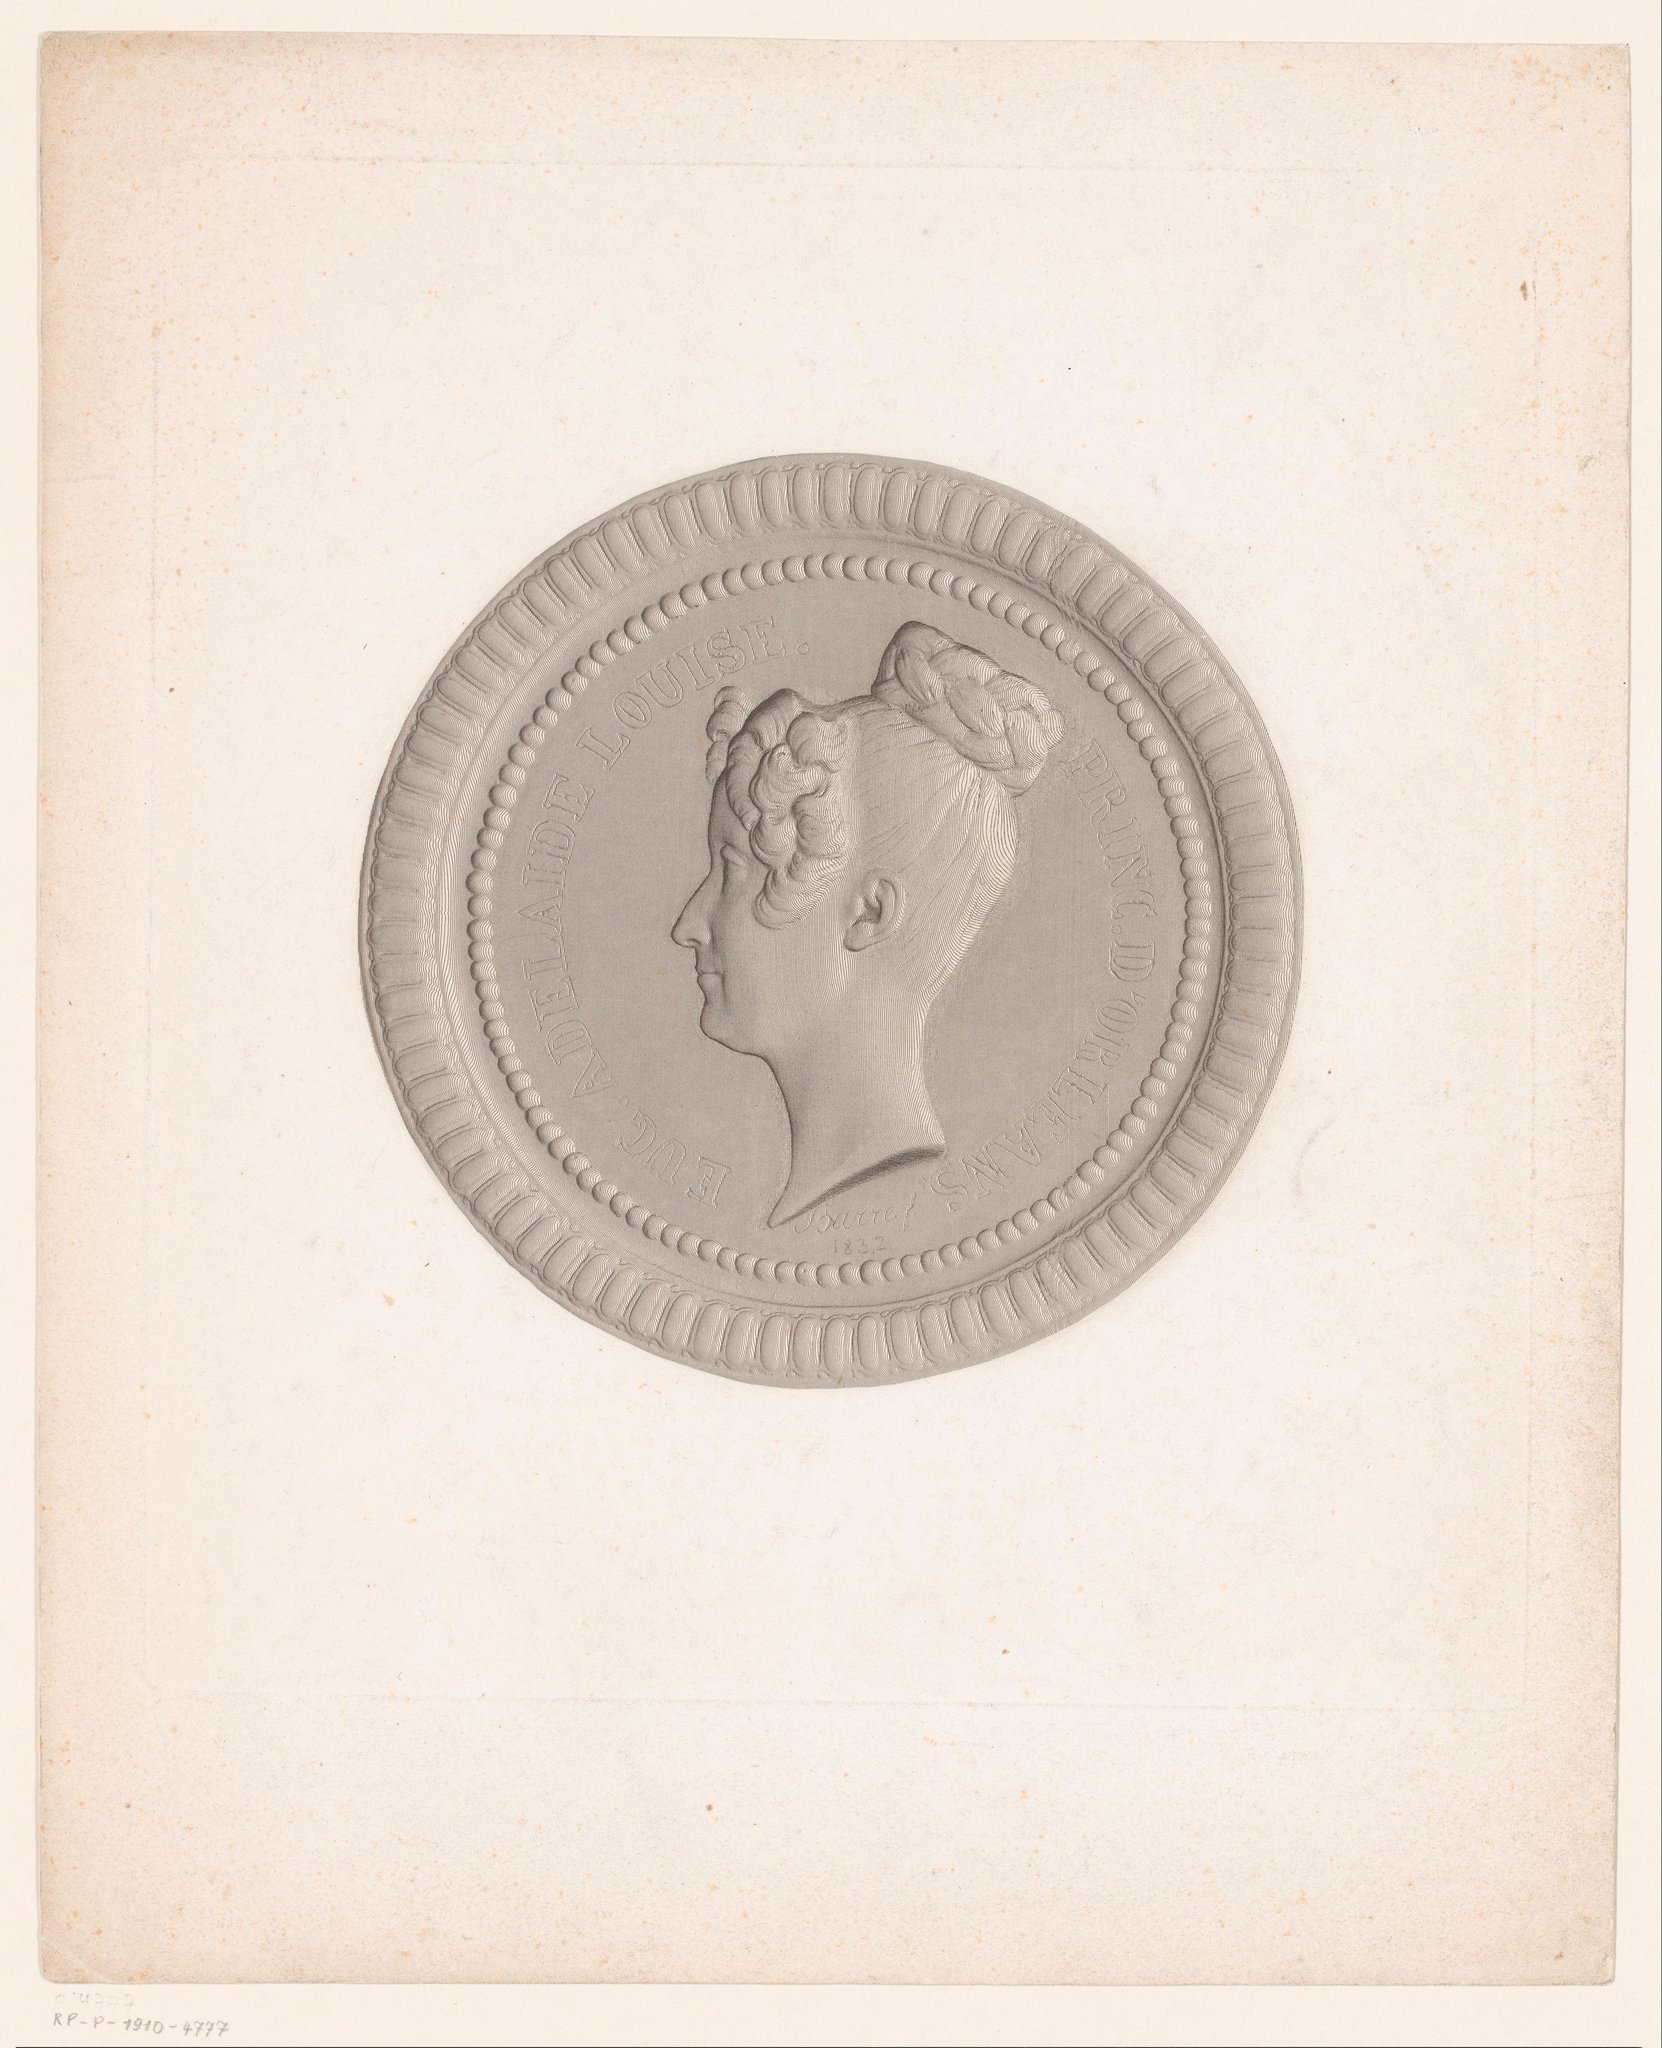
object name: print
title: Princ. D'Orleans Eug. Adelaide Louise.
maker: jean jacques barre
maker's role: print maker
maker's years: 1793-1855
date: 1832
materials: paper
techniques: relief engraving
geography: france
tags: paris, historical persons - bb - woman, ornament ~ medallion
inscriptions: collector's mark: Lugt 2228